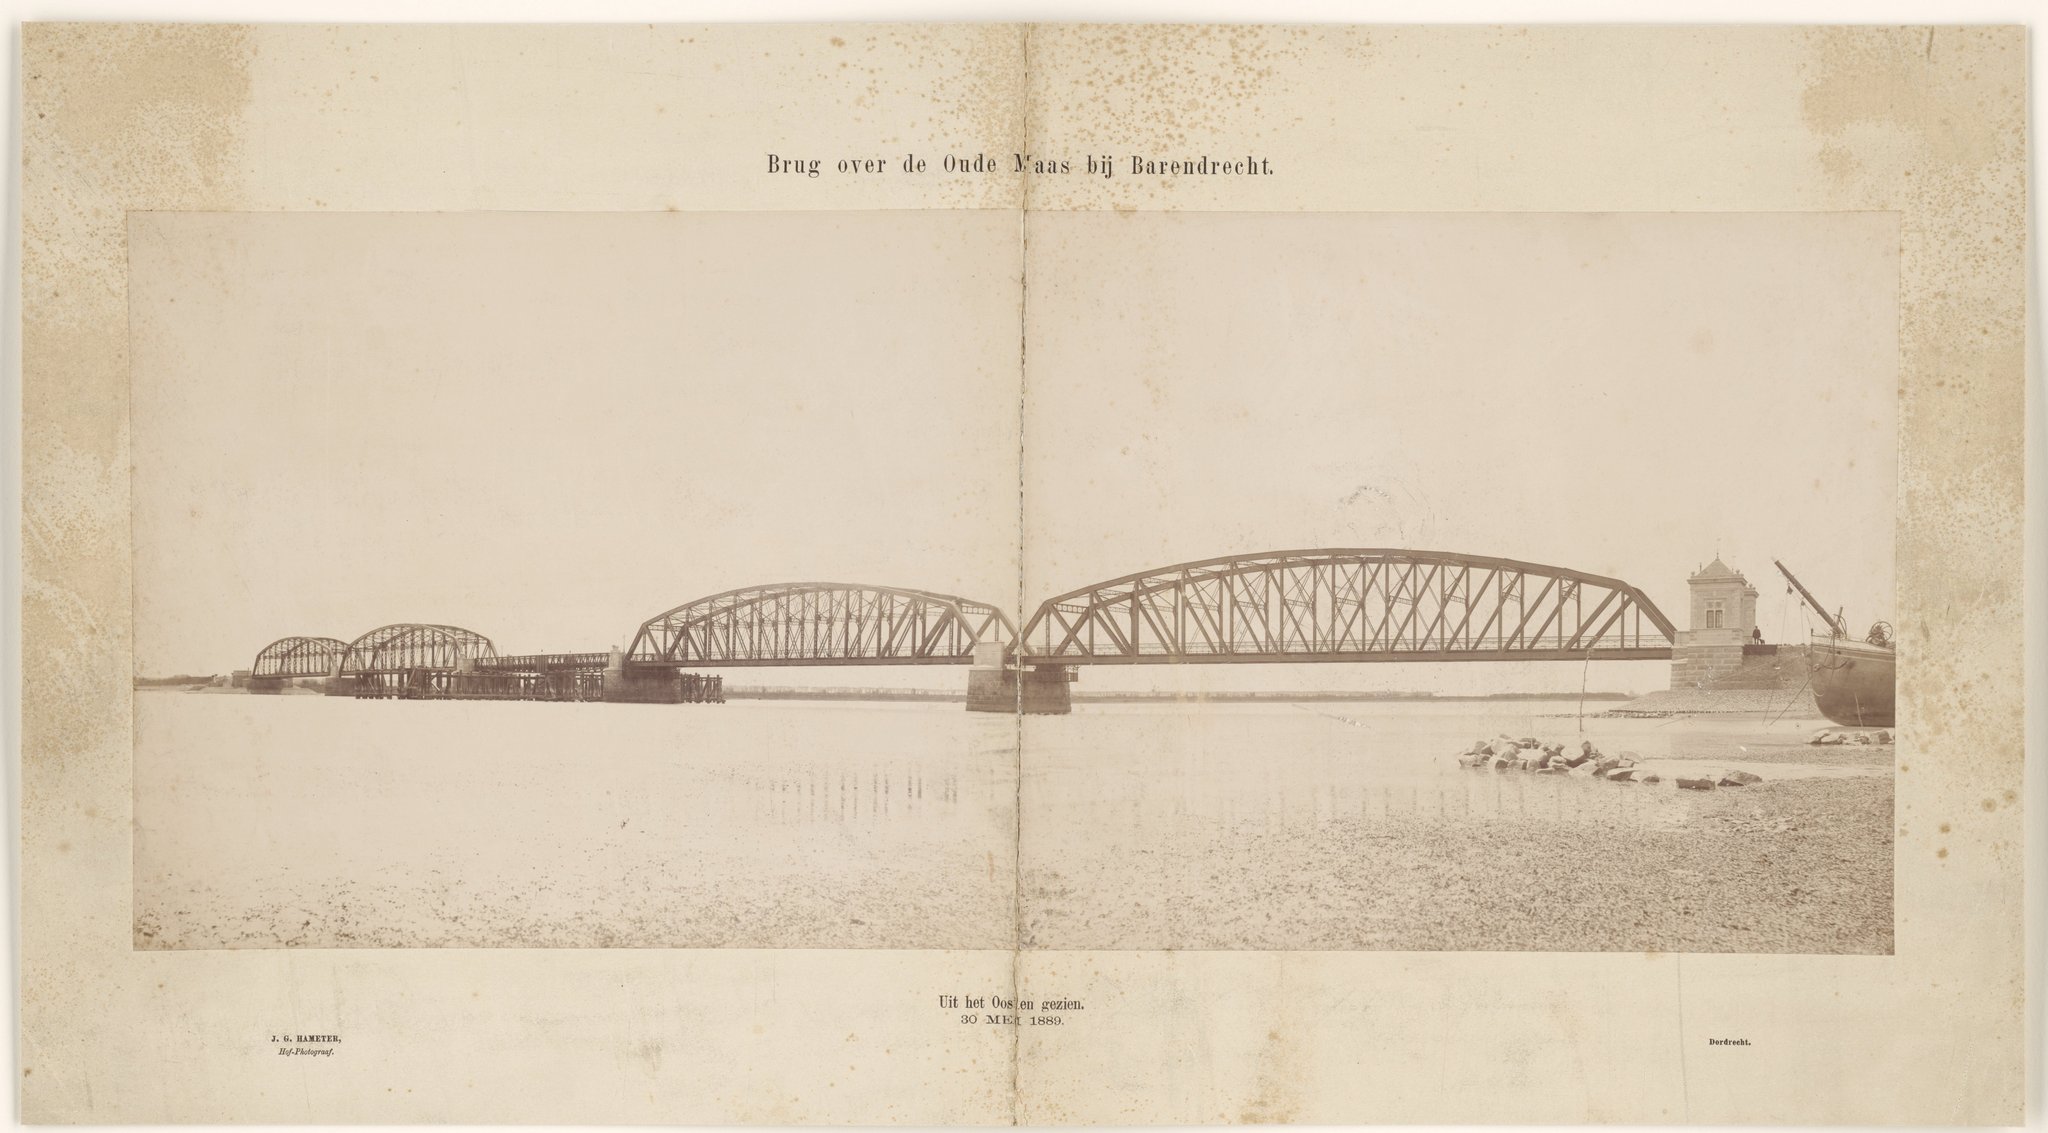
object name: photograph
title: Brug over de Oude Maas bij Barendrecht, aanzicht vanuit het oosten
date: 1889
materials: cardboard, photographic support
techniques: albumen print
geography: netherlands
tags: bridge in city across river, canal, etc.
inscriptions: date